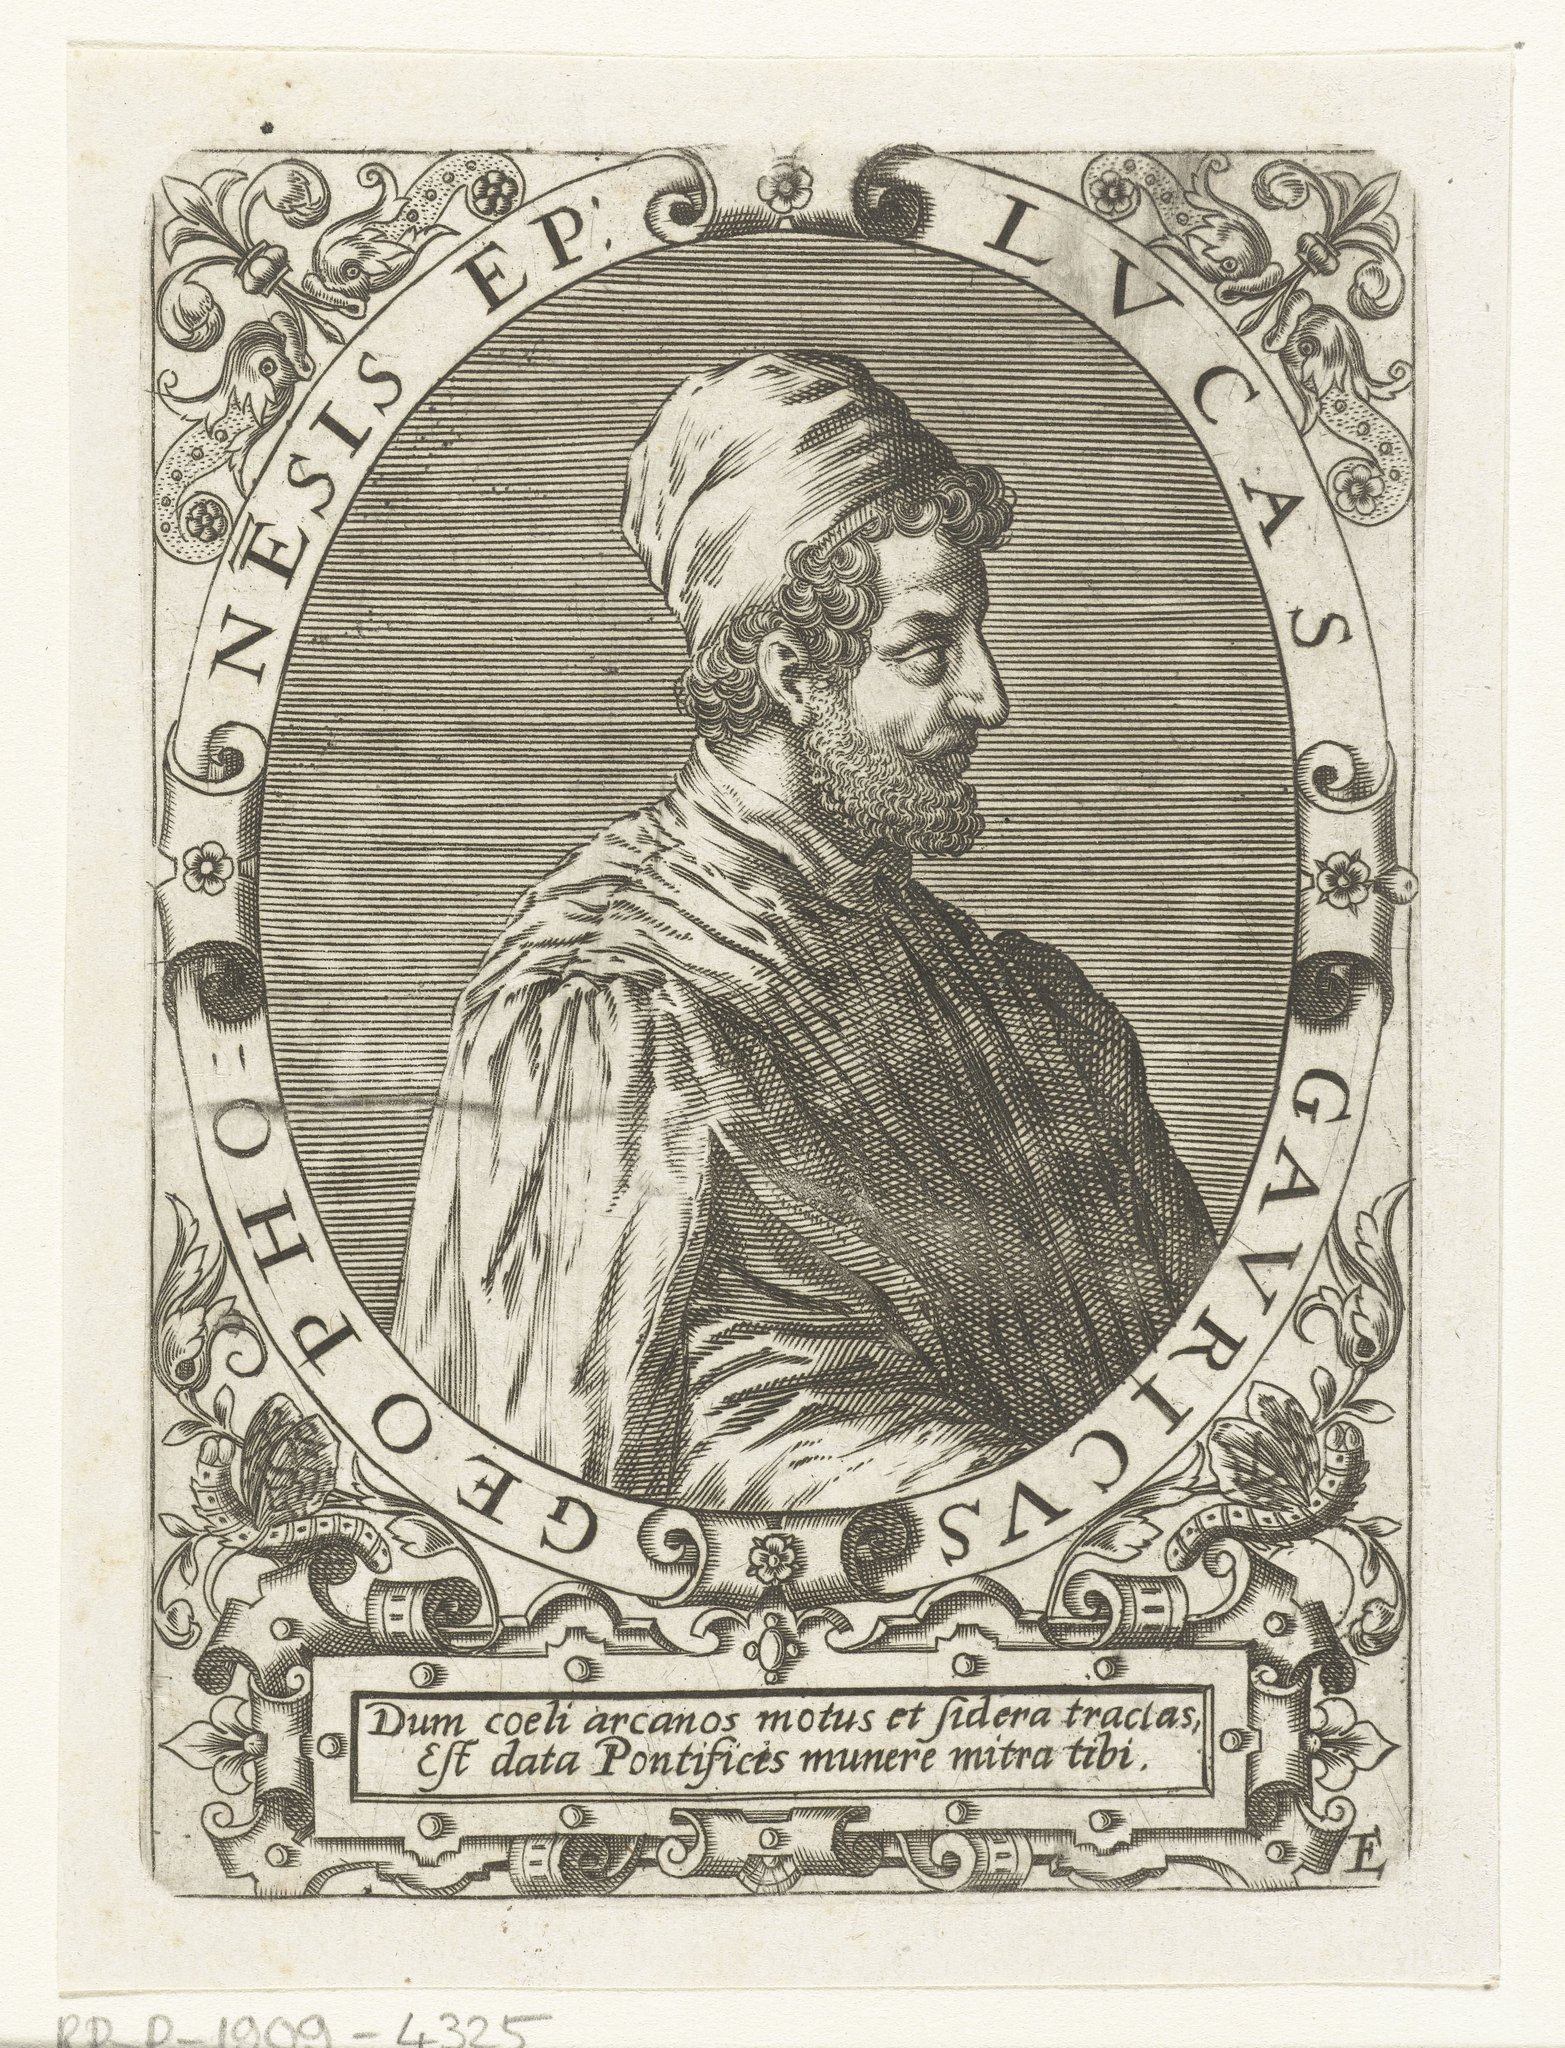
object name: print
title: Portret van Luca Gaurico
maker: jean jacques boissard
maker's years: 1528-1598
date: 1669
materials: paper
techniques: engraving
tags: rome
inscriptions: collector's mark: Lugt 2228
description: Gemaakt voor: J.J. Boissard, Icones virorum illustrium doctrina &c eruditione praestanti um contines. Frankfurt am Main: de Bry, 1597-1599. Opnieuw gebruikt in: J.J.Boissard, Bibliotheca chalcographica, hoc est Virtute et eruditione clarorum Virorum Imagines. Heidelberg: Clemens Ammon, 1669 (te herkennen aan de toegevoegde signatuur in de rechter onderhoek: E).